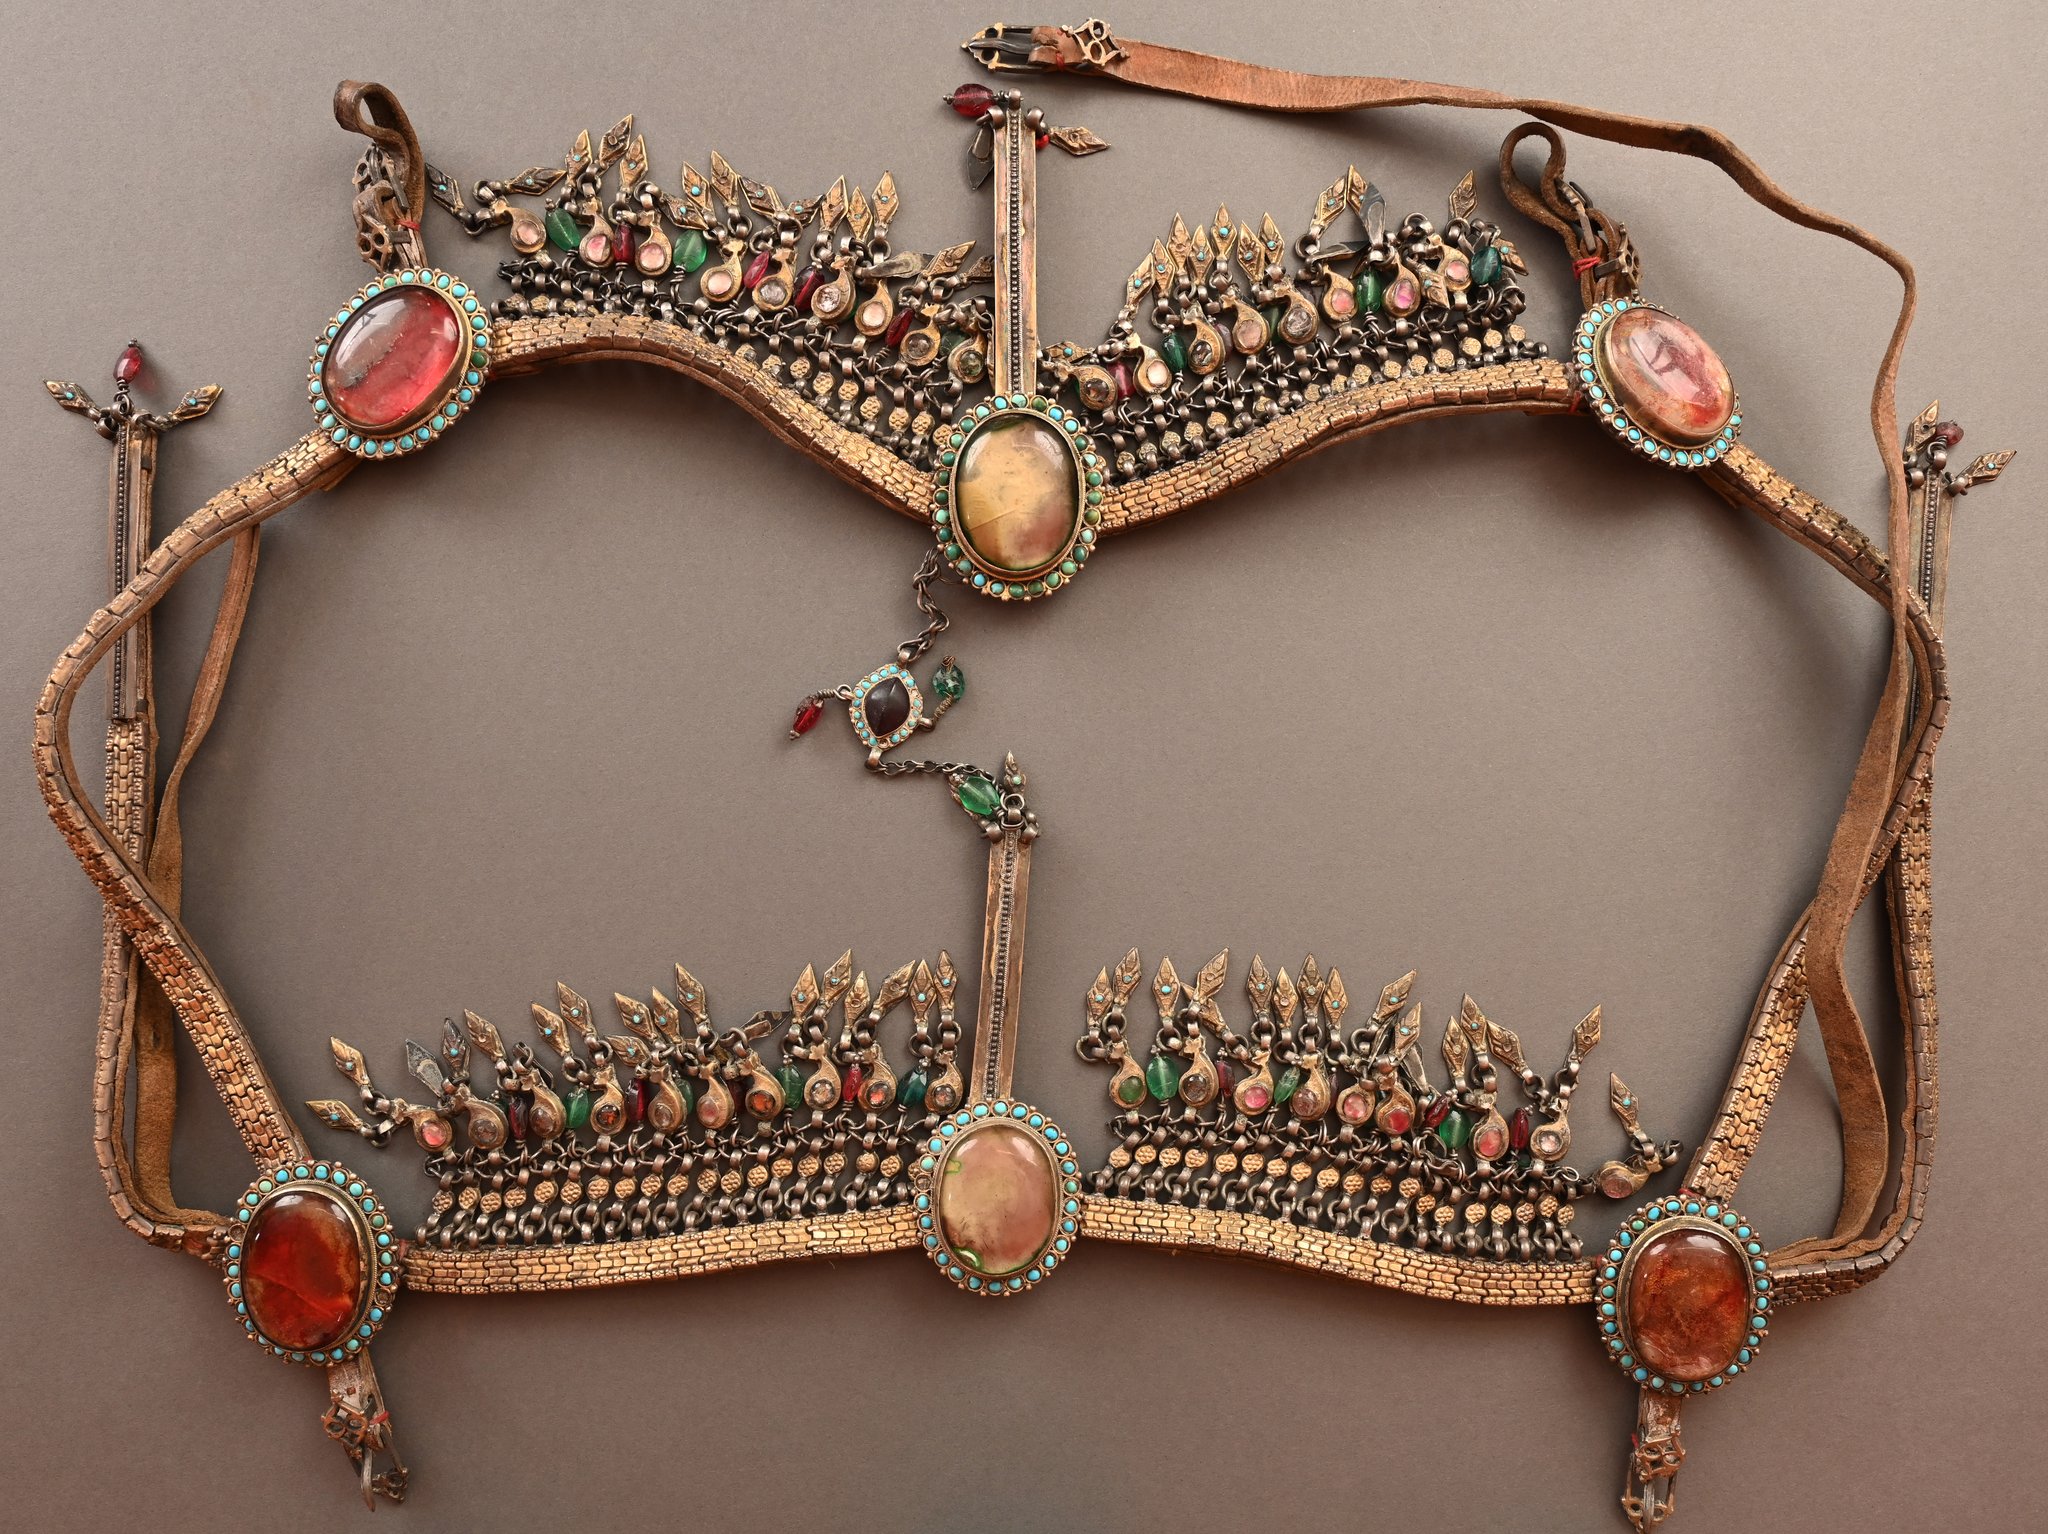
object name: headstall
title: Headstall with Reins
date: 1801-1900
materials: glass, leather, silver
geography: iran